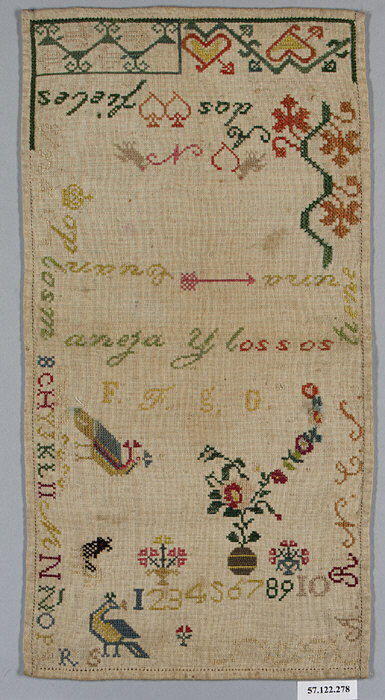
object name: sampler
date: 1801-1900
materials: cotton, silk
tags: birds,plants